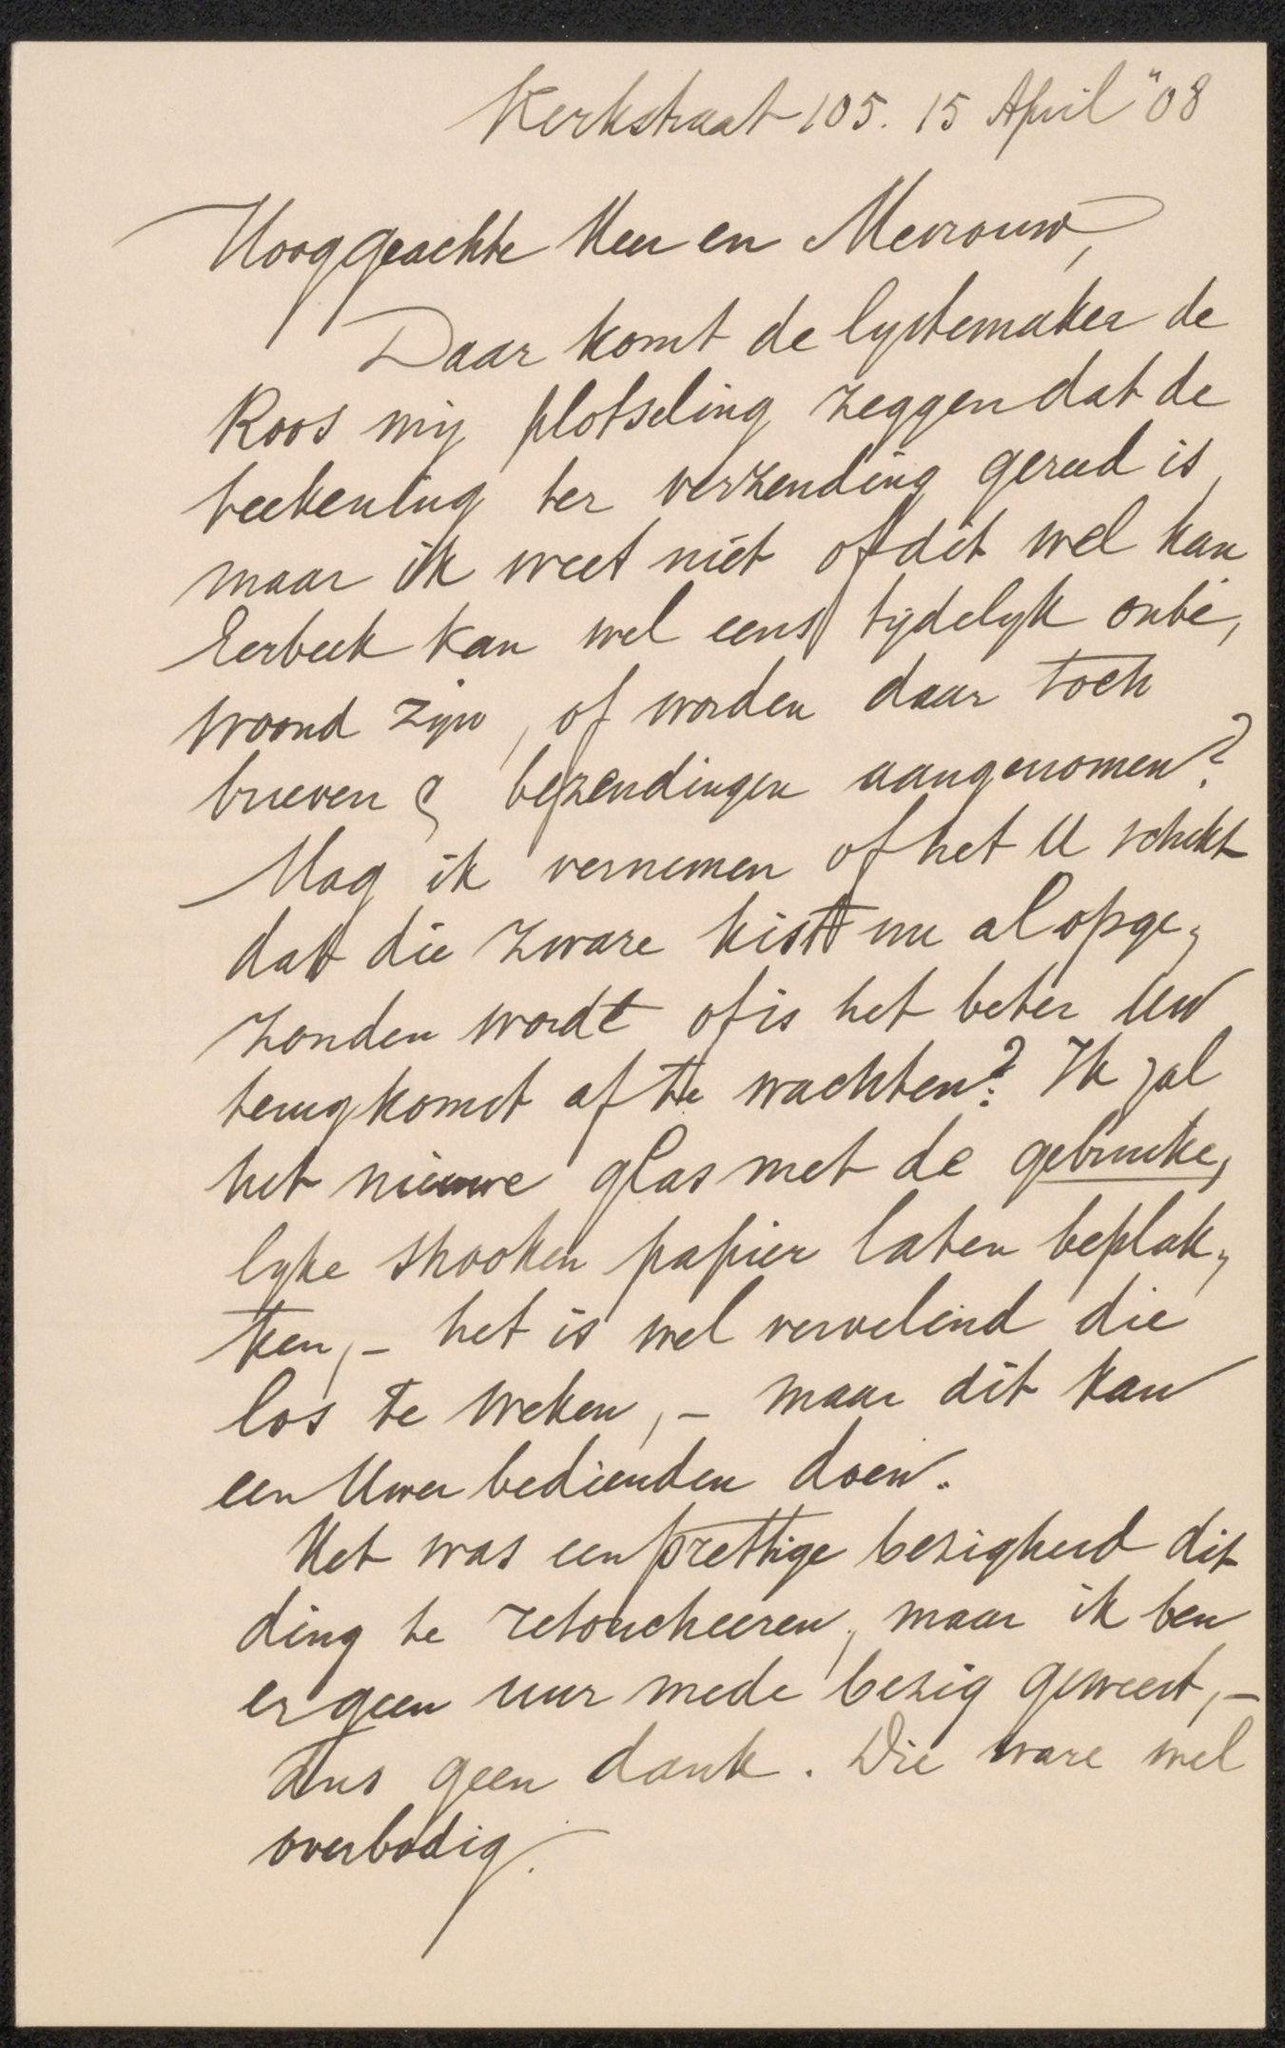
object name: letter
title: Brief aan Max Wilhelm Carl Weber en Anne Antoinette Weber-Van Bosse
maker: august allebé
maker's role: draughtsman, print maker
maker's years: 1838-1927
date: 1908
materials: ink, paper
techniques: pen, writing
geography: amsterdam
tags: rotterdam, charles albert de burlet, amsterdam, anne antoinette weber-van bosse, jonkheer jan six, drawing, painting (including book-illumination, miniature-painting)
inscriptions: watermark